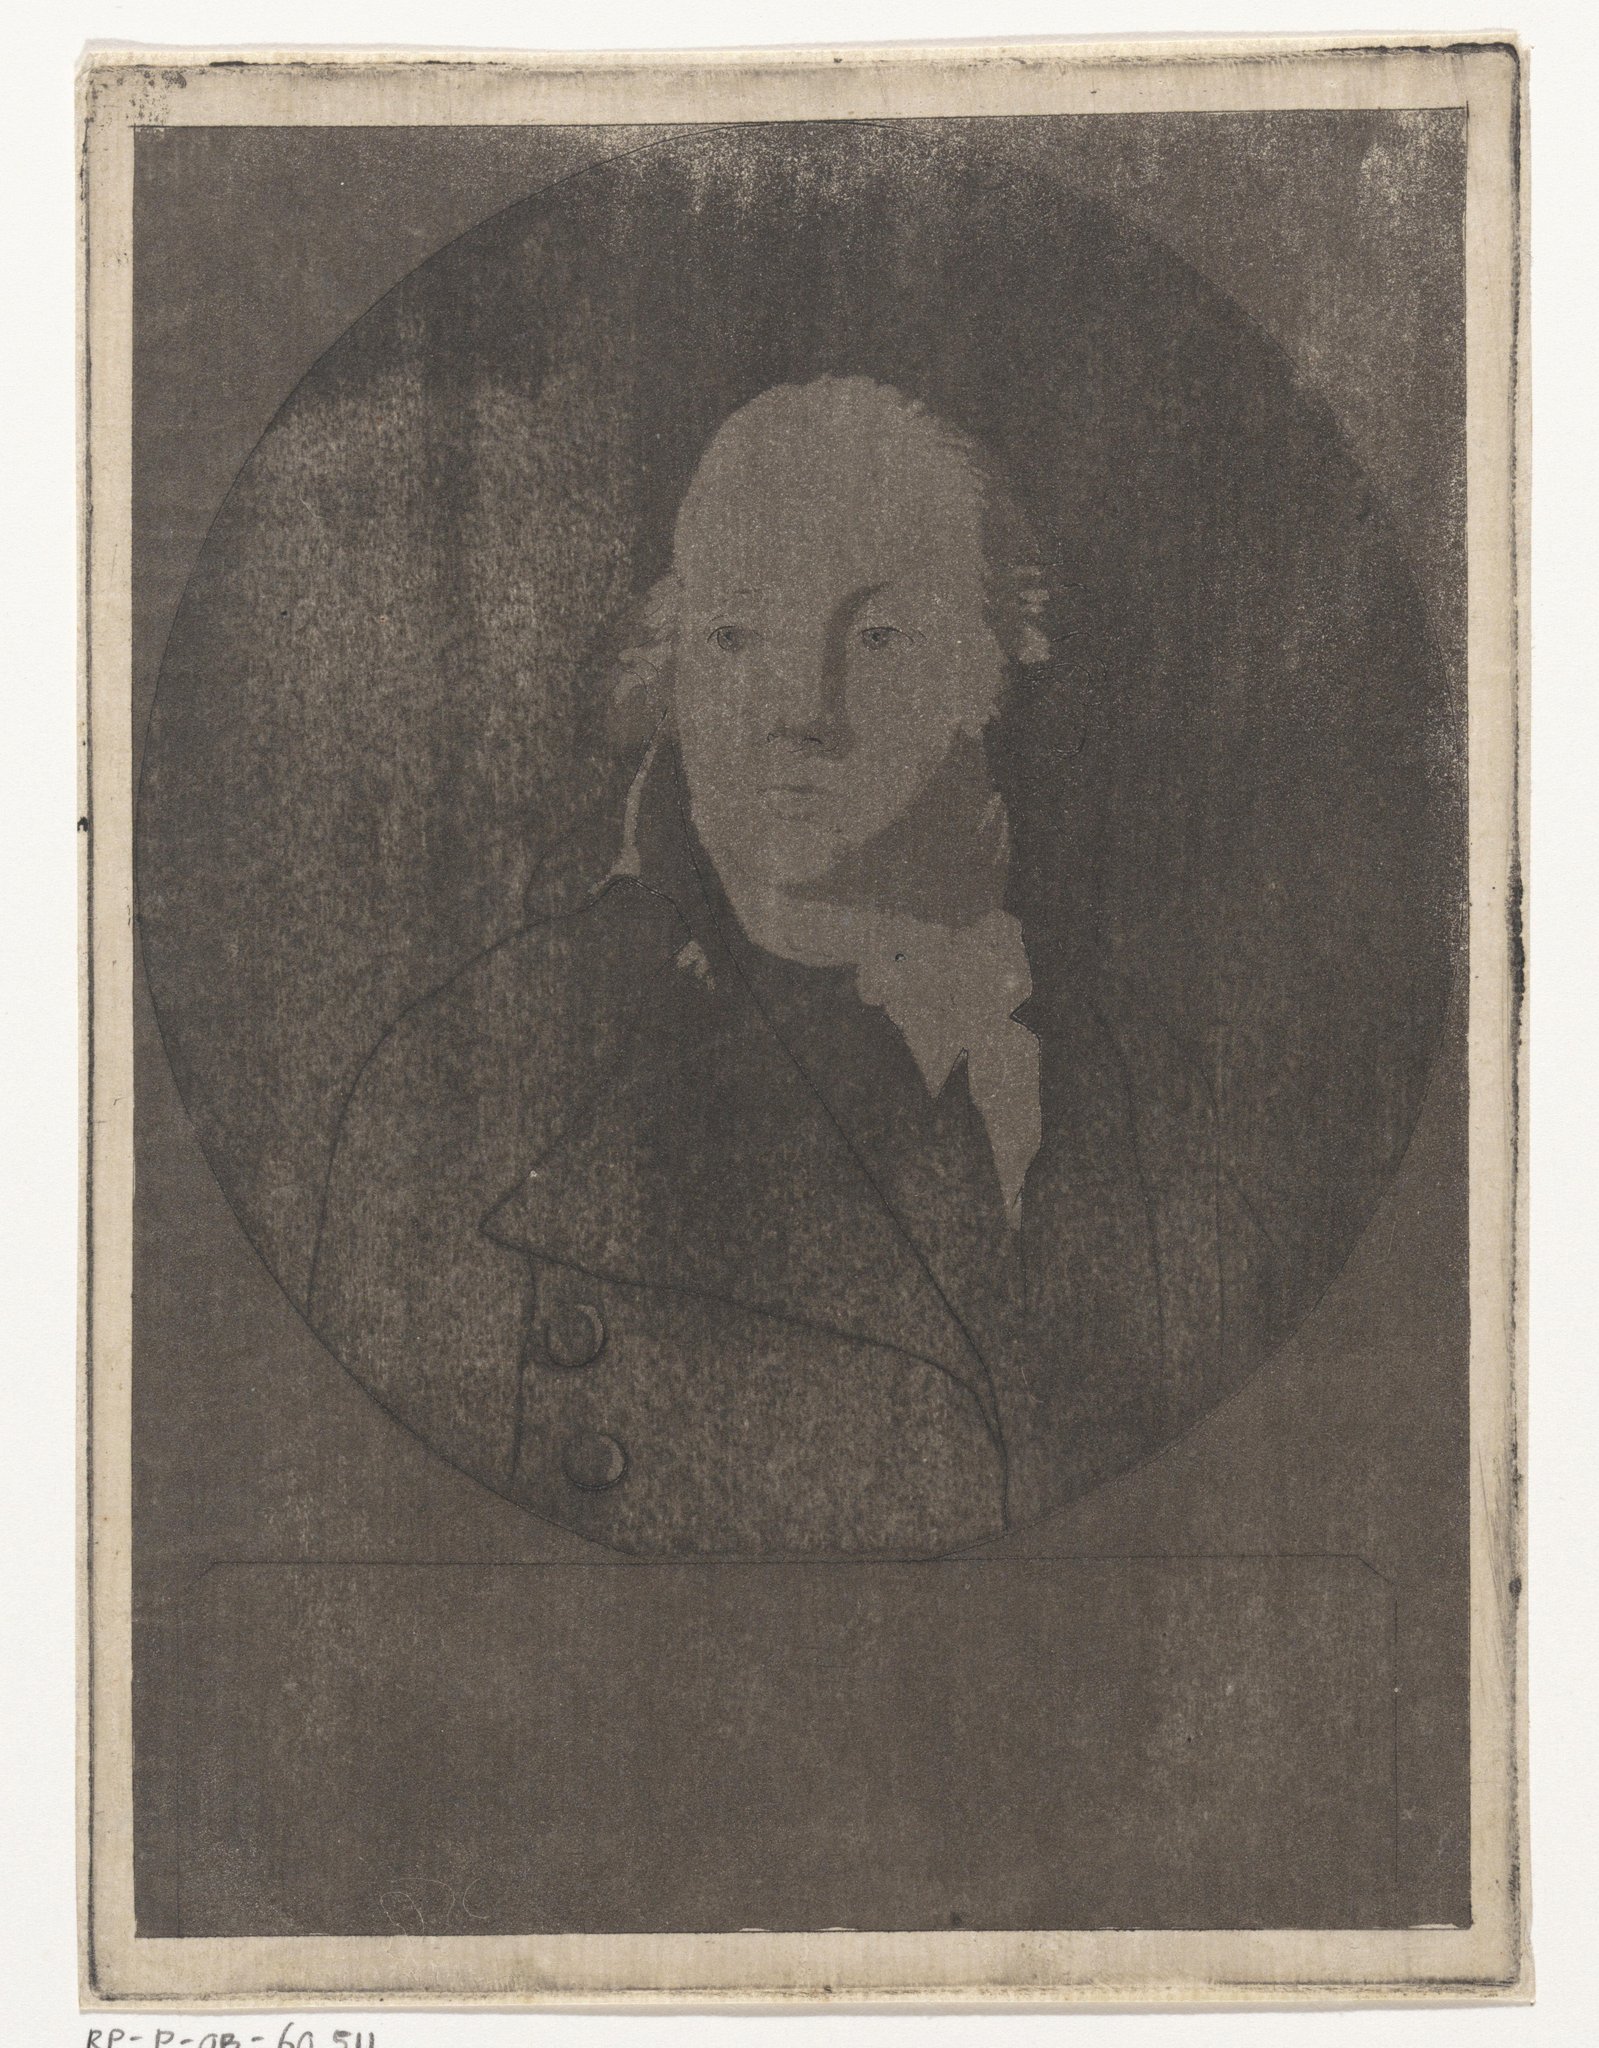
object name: print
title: Portret van Jan Hinlopen(?)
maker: johan bernard scheffer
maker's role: draughtsman, painter, print maker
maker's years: 1765-1809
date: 1788-1809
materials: paper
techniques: aquatint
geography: northern netherlands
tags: historical persons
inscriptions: collector's mark: Lugt 2228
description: Scheffer maakte in 1788 een geschilderd portret van Jan Hinlopen (1759-1808), raad in de vroedschap. Dit is mogelijk ook een portret van Hinlopen.